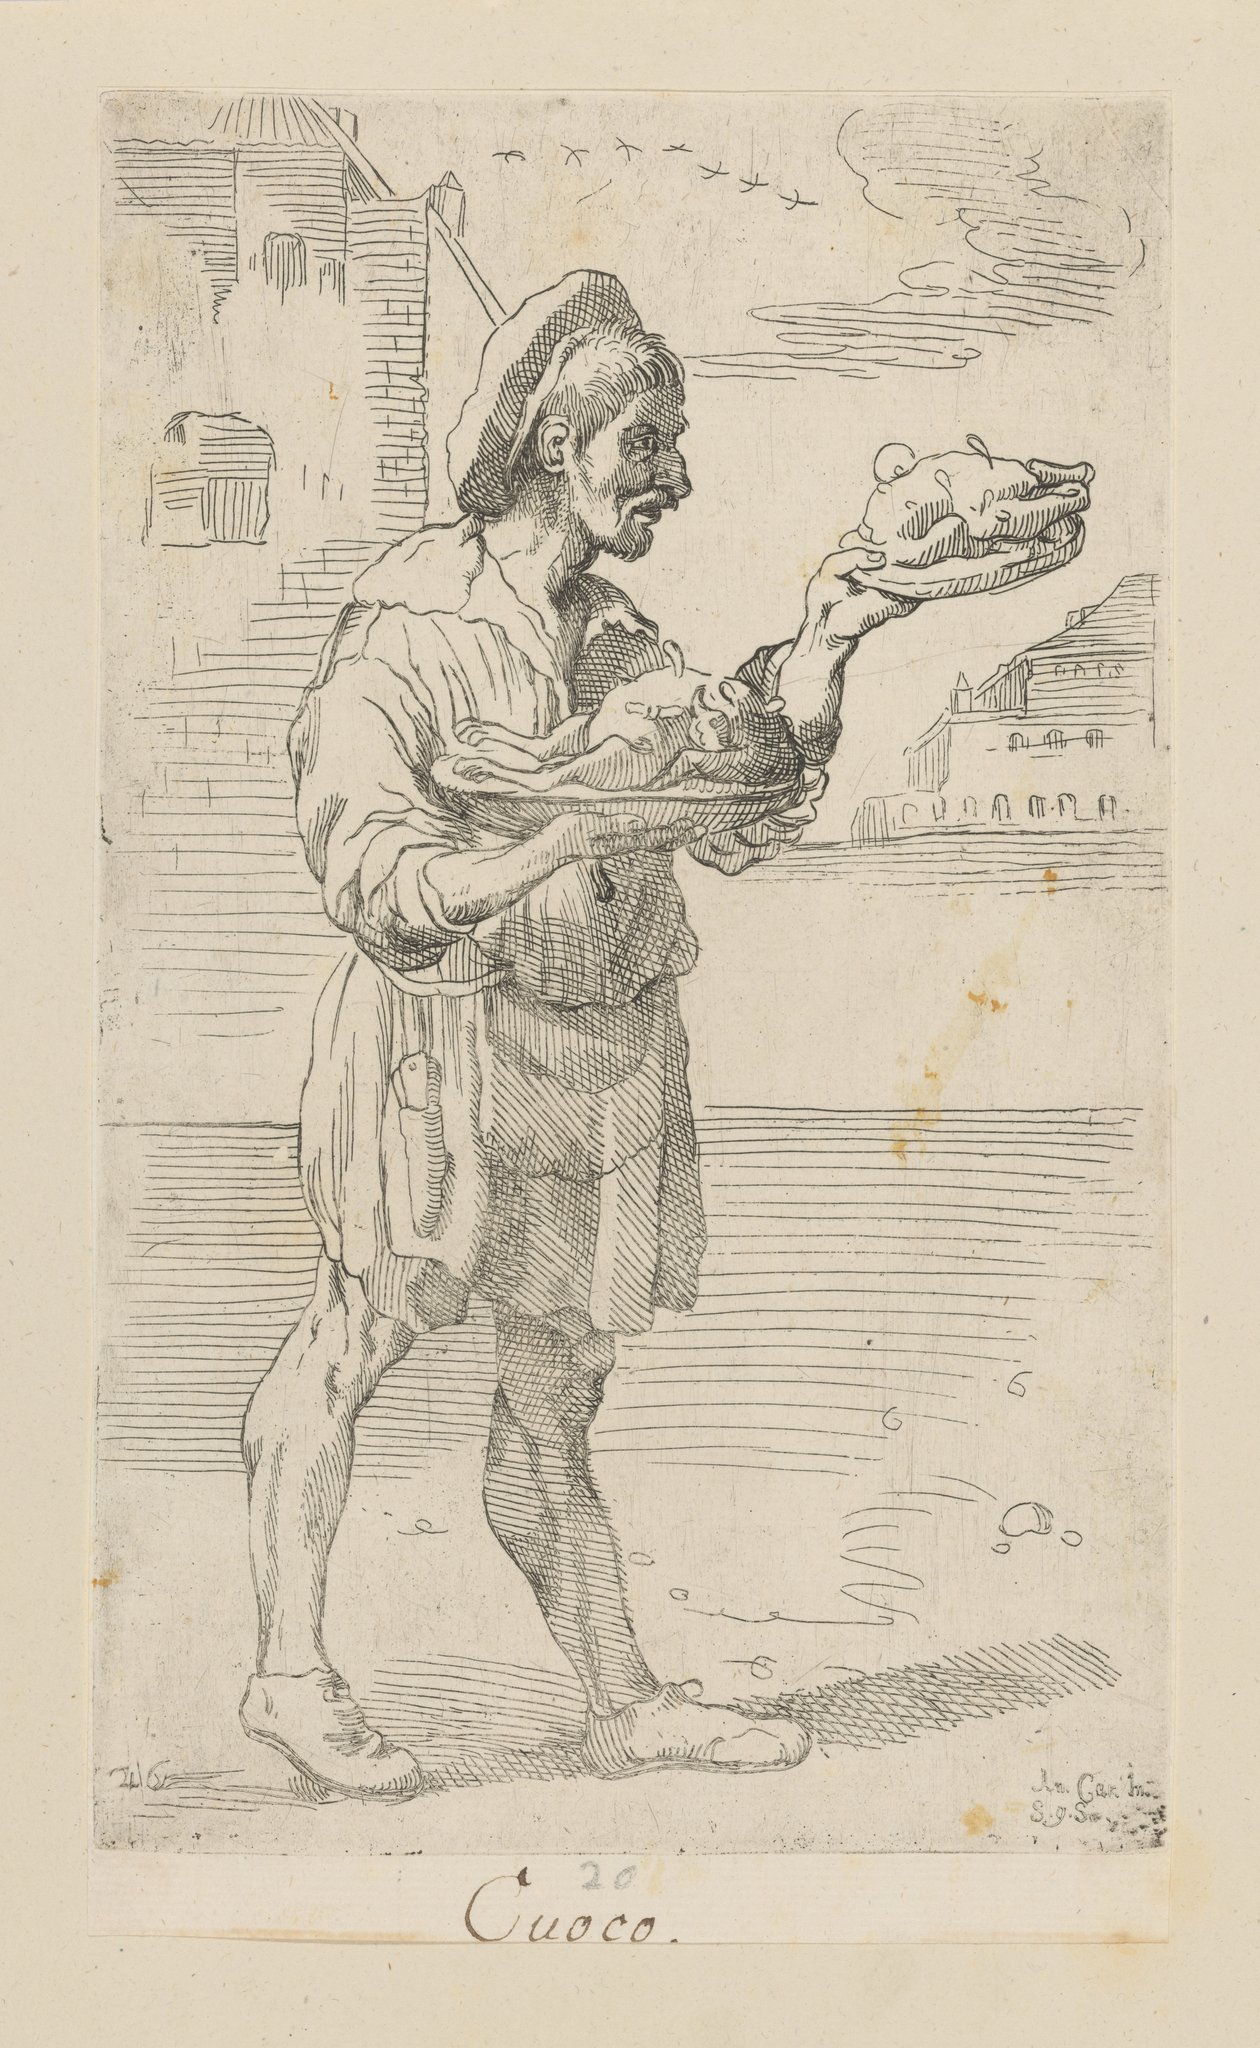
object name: print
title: Plate 16: Cook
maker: simon guillain ii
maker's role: artist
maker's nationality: french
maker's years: 1618-1718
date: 1646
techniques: etching